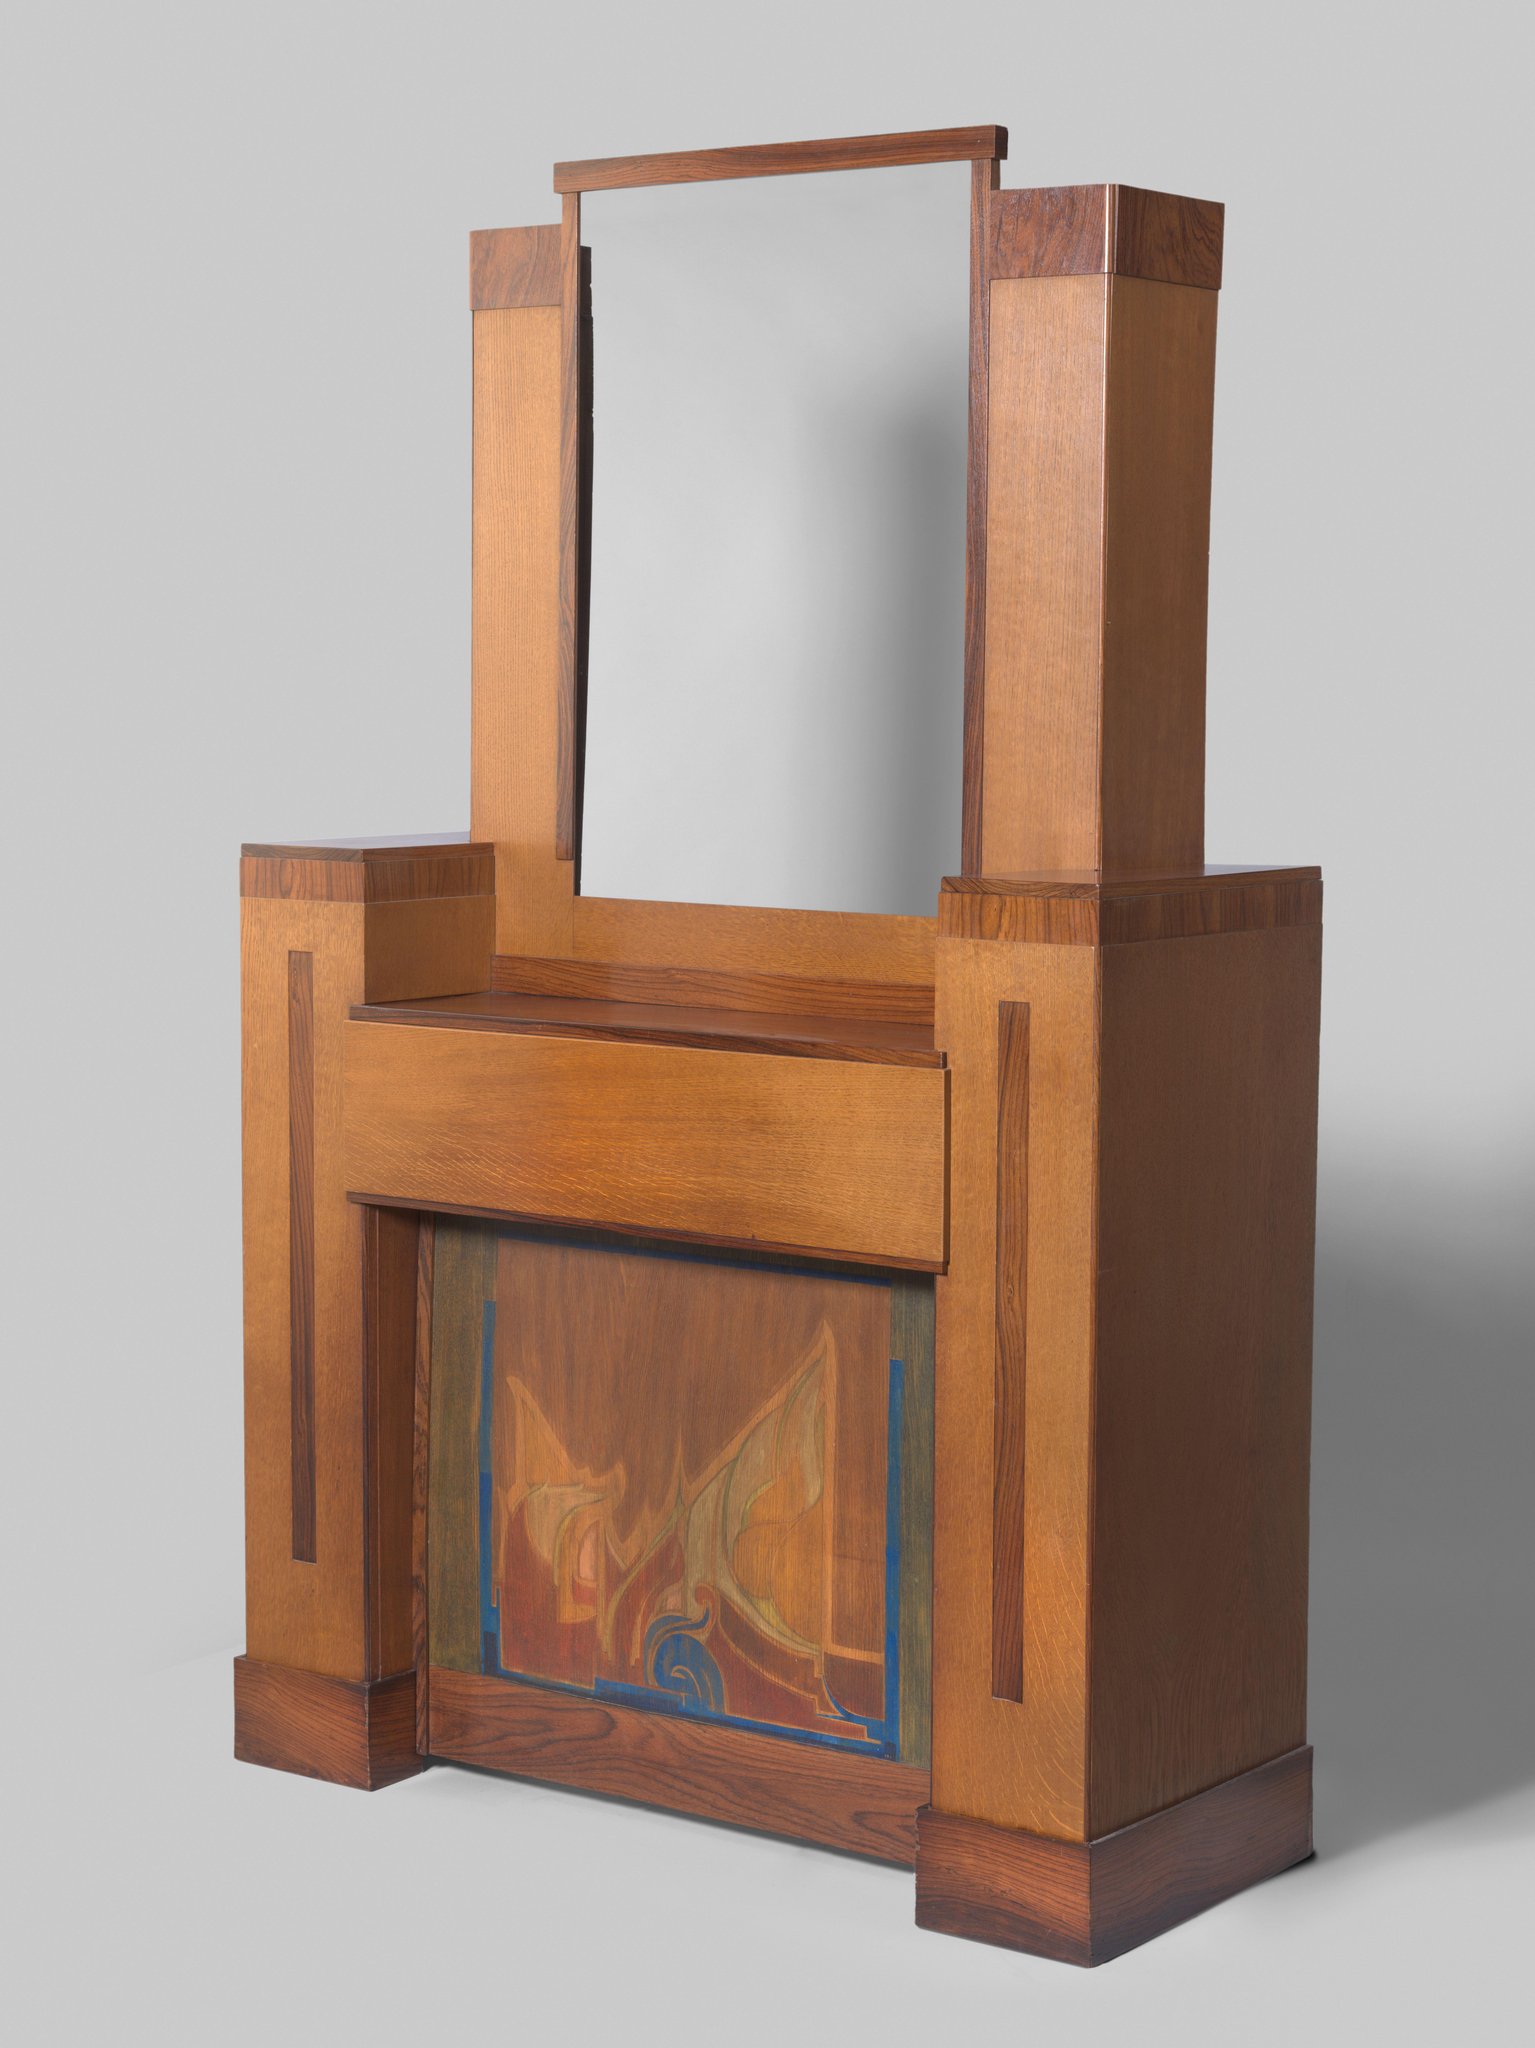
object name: furniture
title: Schoorsteenbetimmering met een pentekening van een roofvogel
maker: ernst schubad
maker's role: interieurontwerper, meubelontwerper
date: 1910-1927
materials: wood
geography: netherlands